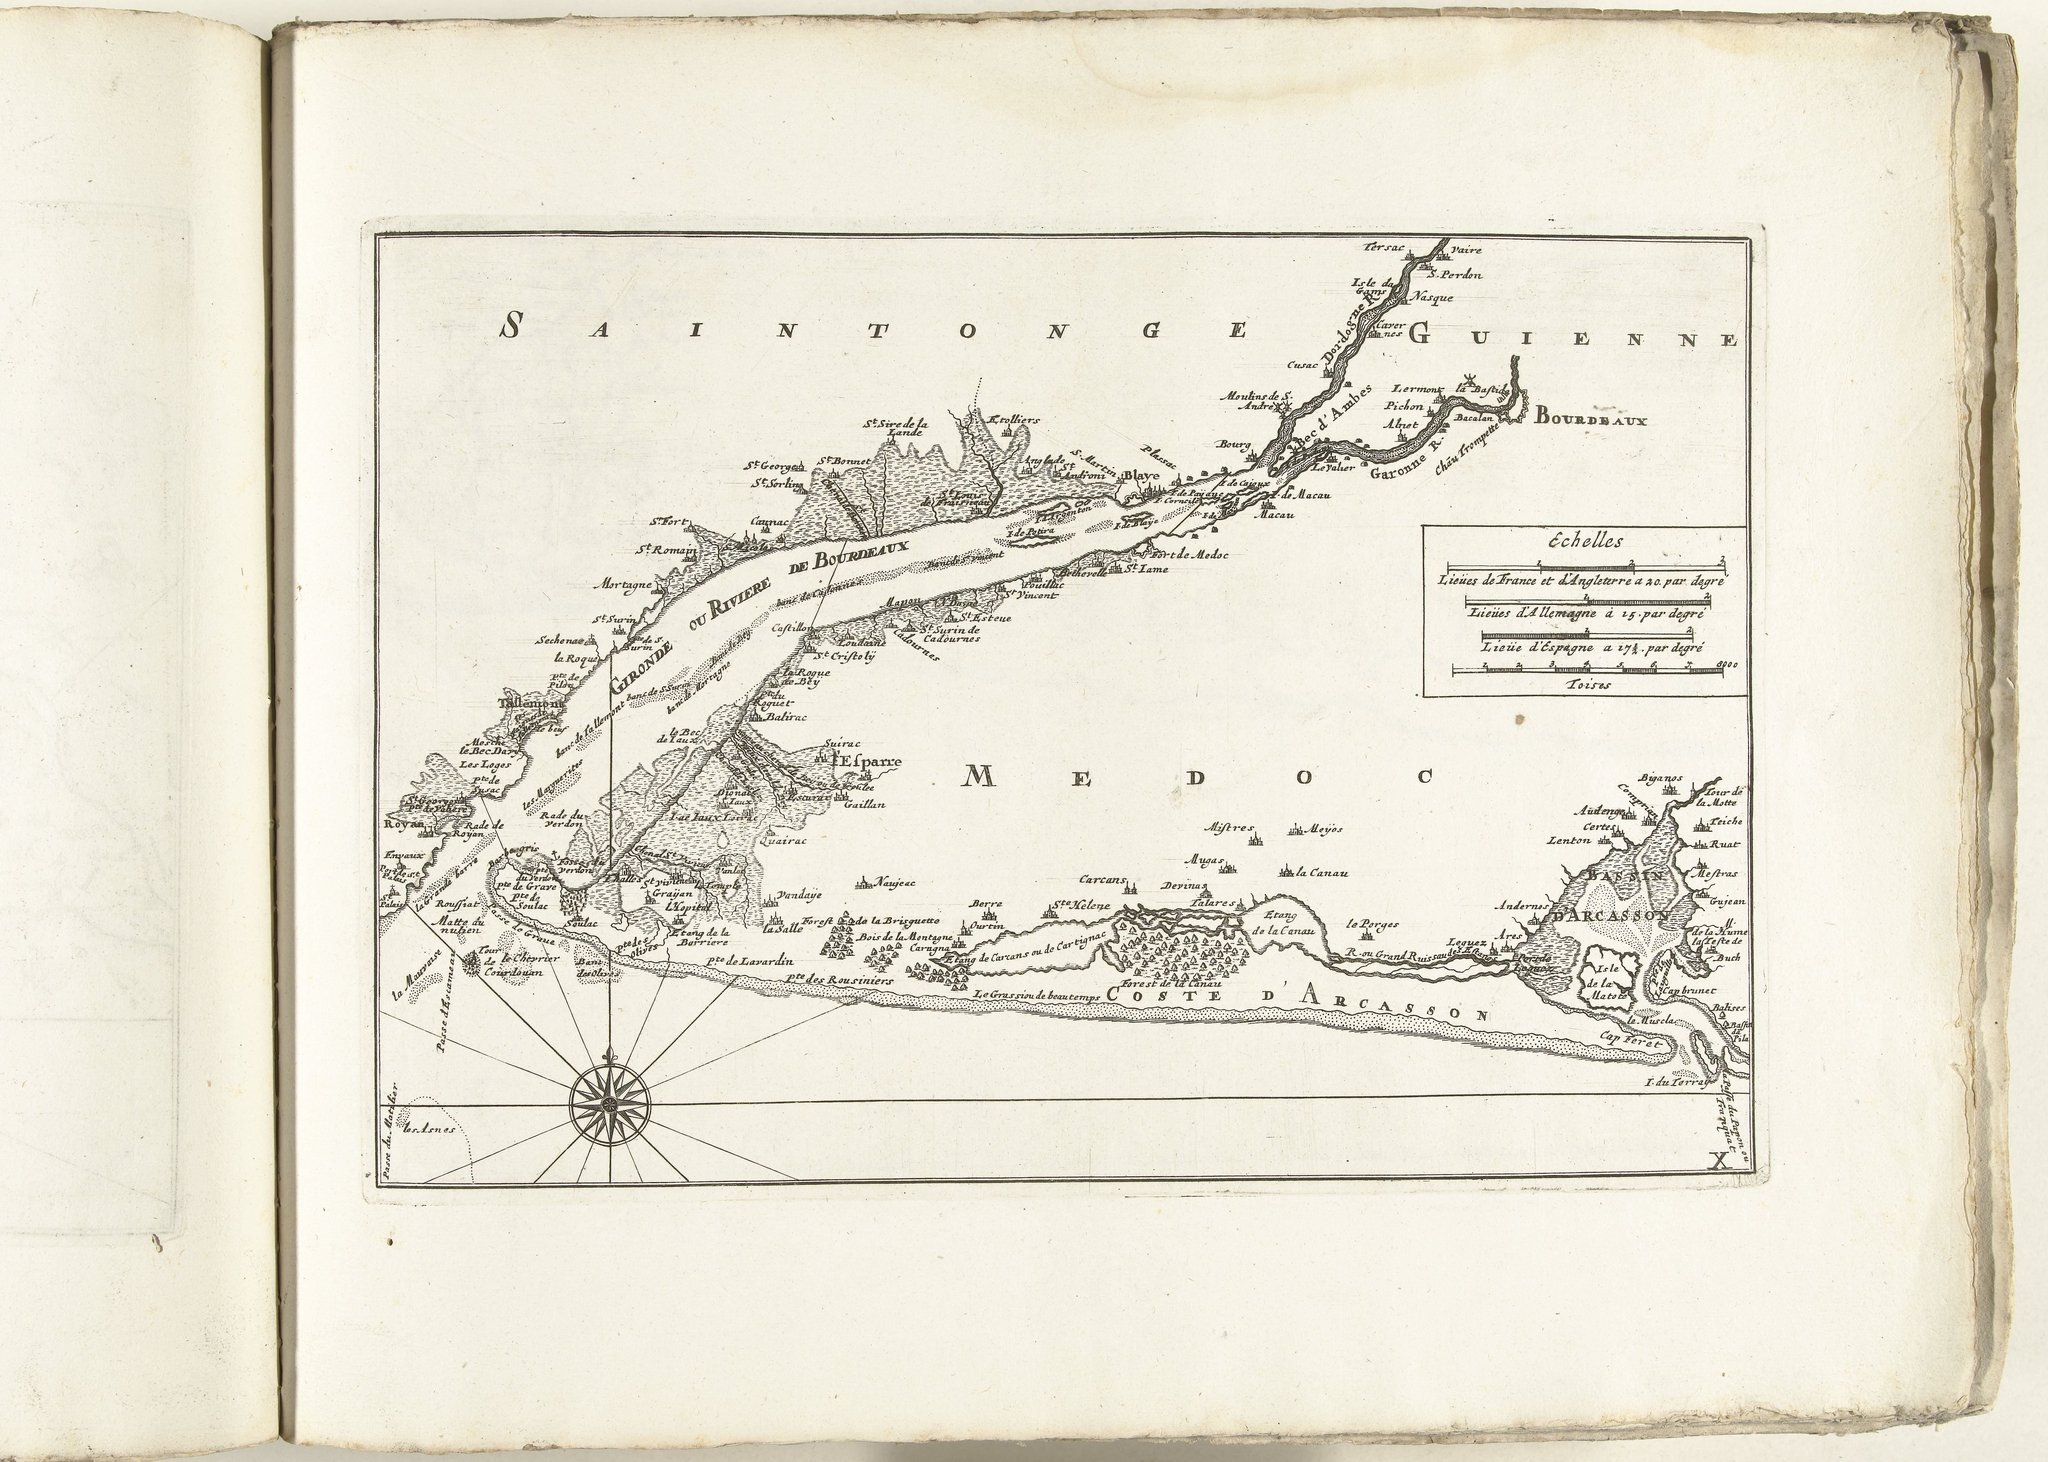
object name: map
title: Kaart van de Franse westkust met de monding van de Garonne en Dordogne, ca. 1702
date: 1702-1703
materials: paper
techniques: etching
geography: amsterdam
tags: maps of separate countries or regions, france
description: Kaart van de Franse westkust met de monding van de Garonne en Dordogne. Gemerkt rechtsonder: X. Onderdeel van het tweede van twee delen van het prentwerk: Les costes de France et d'Espagne (oftewel deel 14 van: Les Forces de l'Europe, Asie, Afrique et Amerique), uitgegeven ca. 1702. Het prentwerk bestaat in totaal uit 43 gemerkte platen van de kust van Frankrijk en Spanje, in het kader van de Spaanse Successieoorlog. Deze platen zijn gekopieerd naar anonieme Franse platen oorspronkelijk uitgegeven door Nicolas de Fer te Parijs. Titel en opschriften in de plaat in het Frans.